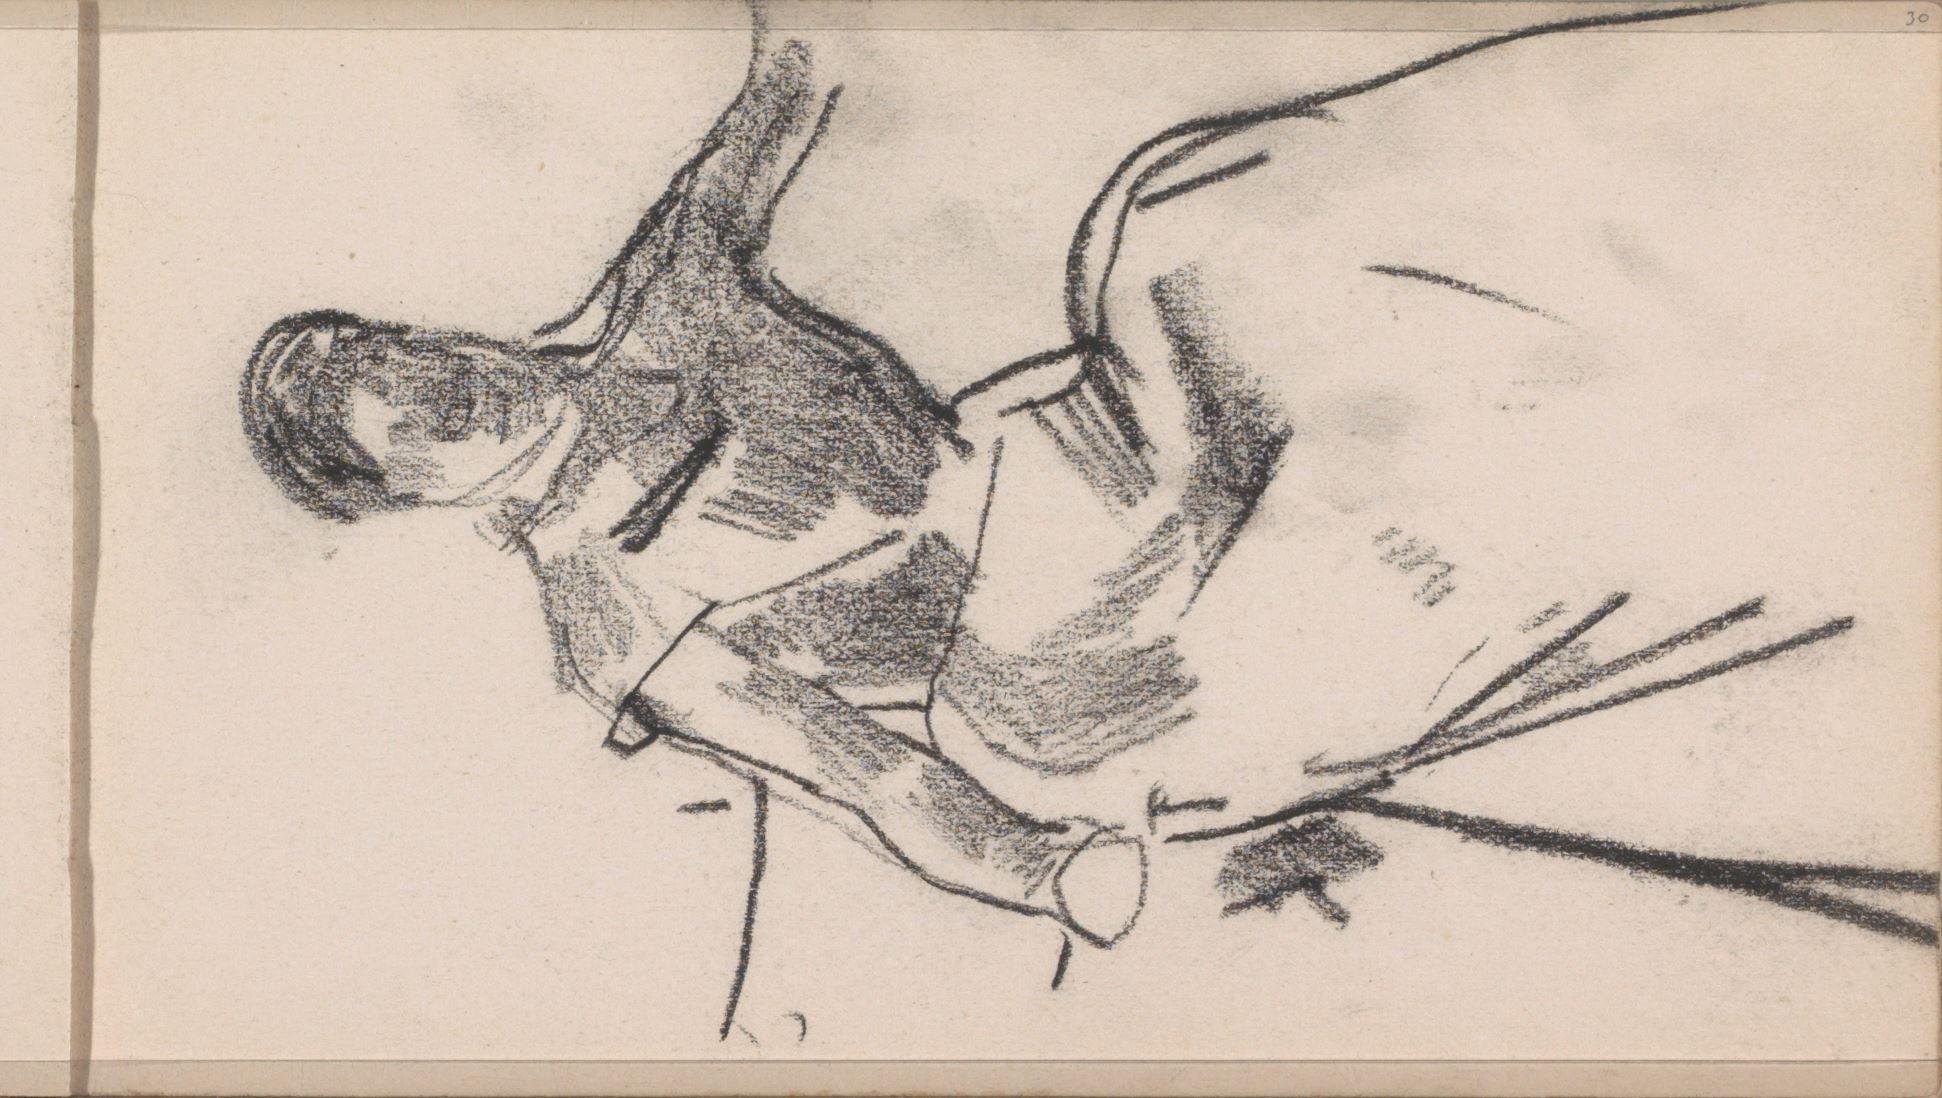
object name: sketchbook leaf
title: Zittende vrouw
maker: george hendrik breitner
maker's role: draughtsman, painter, print maker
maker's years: 1857-1923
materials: chalk, paper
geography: amsterdam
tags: sitting figure - aa - female human figure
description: Pagina 30 uit een schetsboek met 32 bladen.